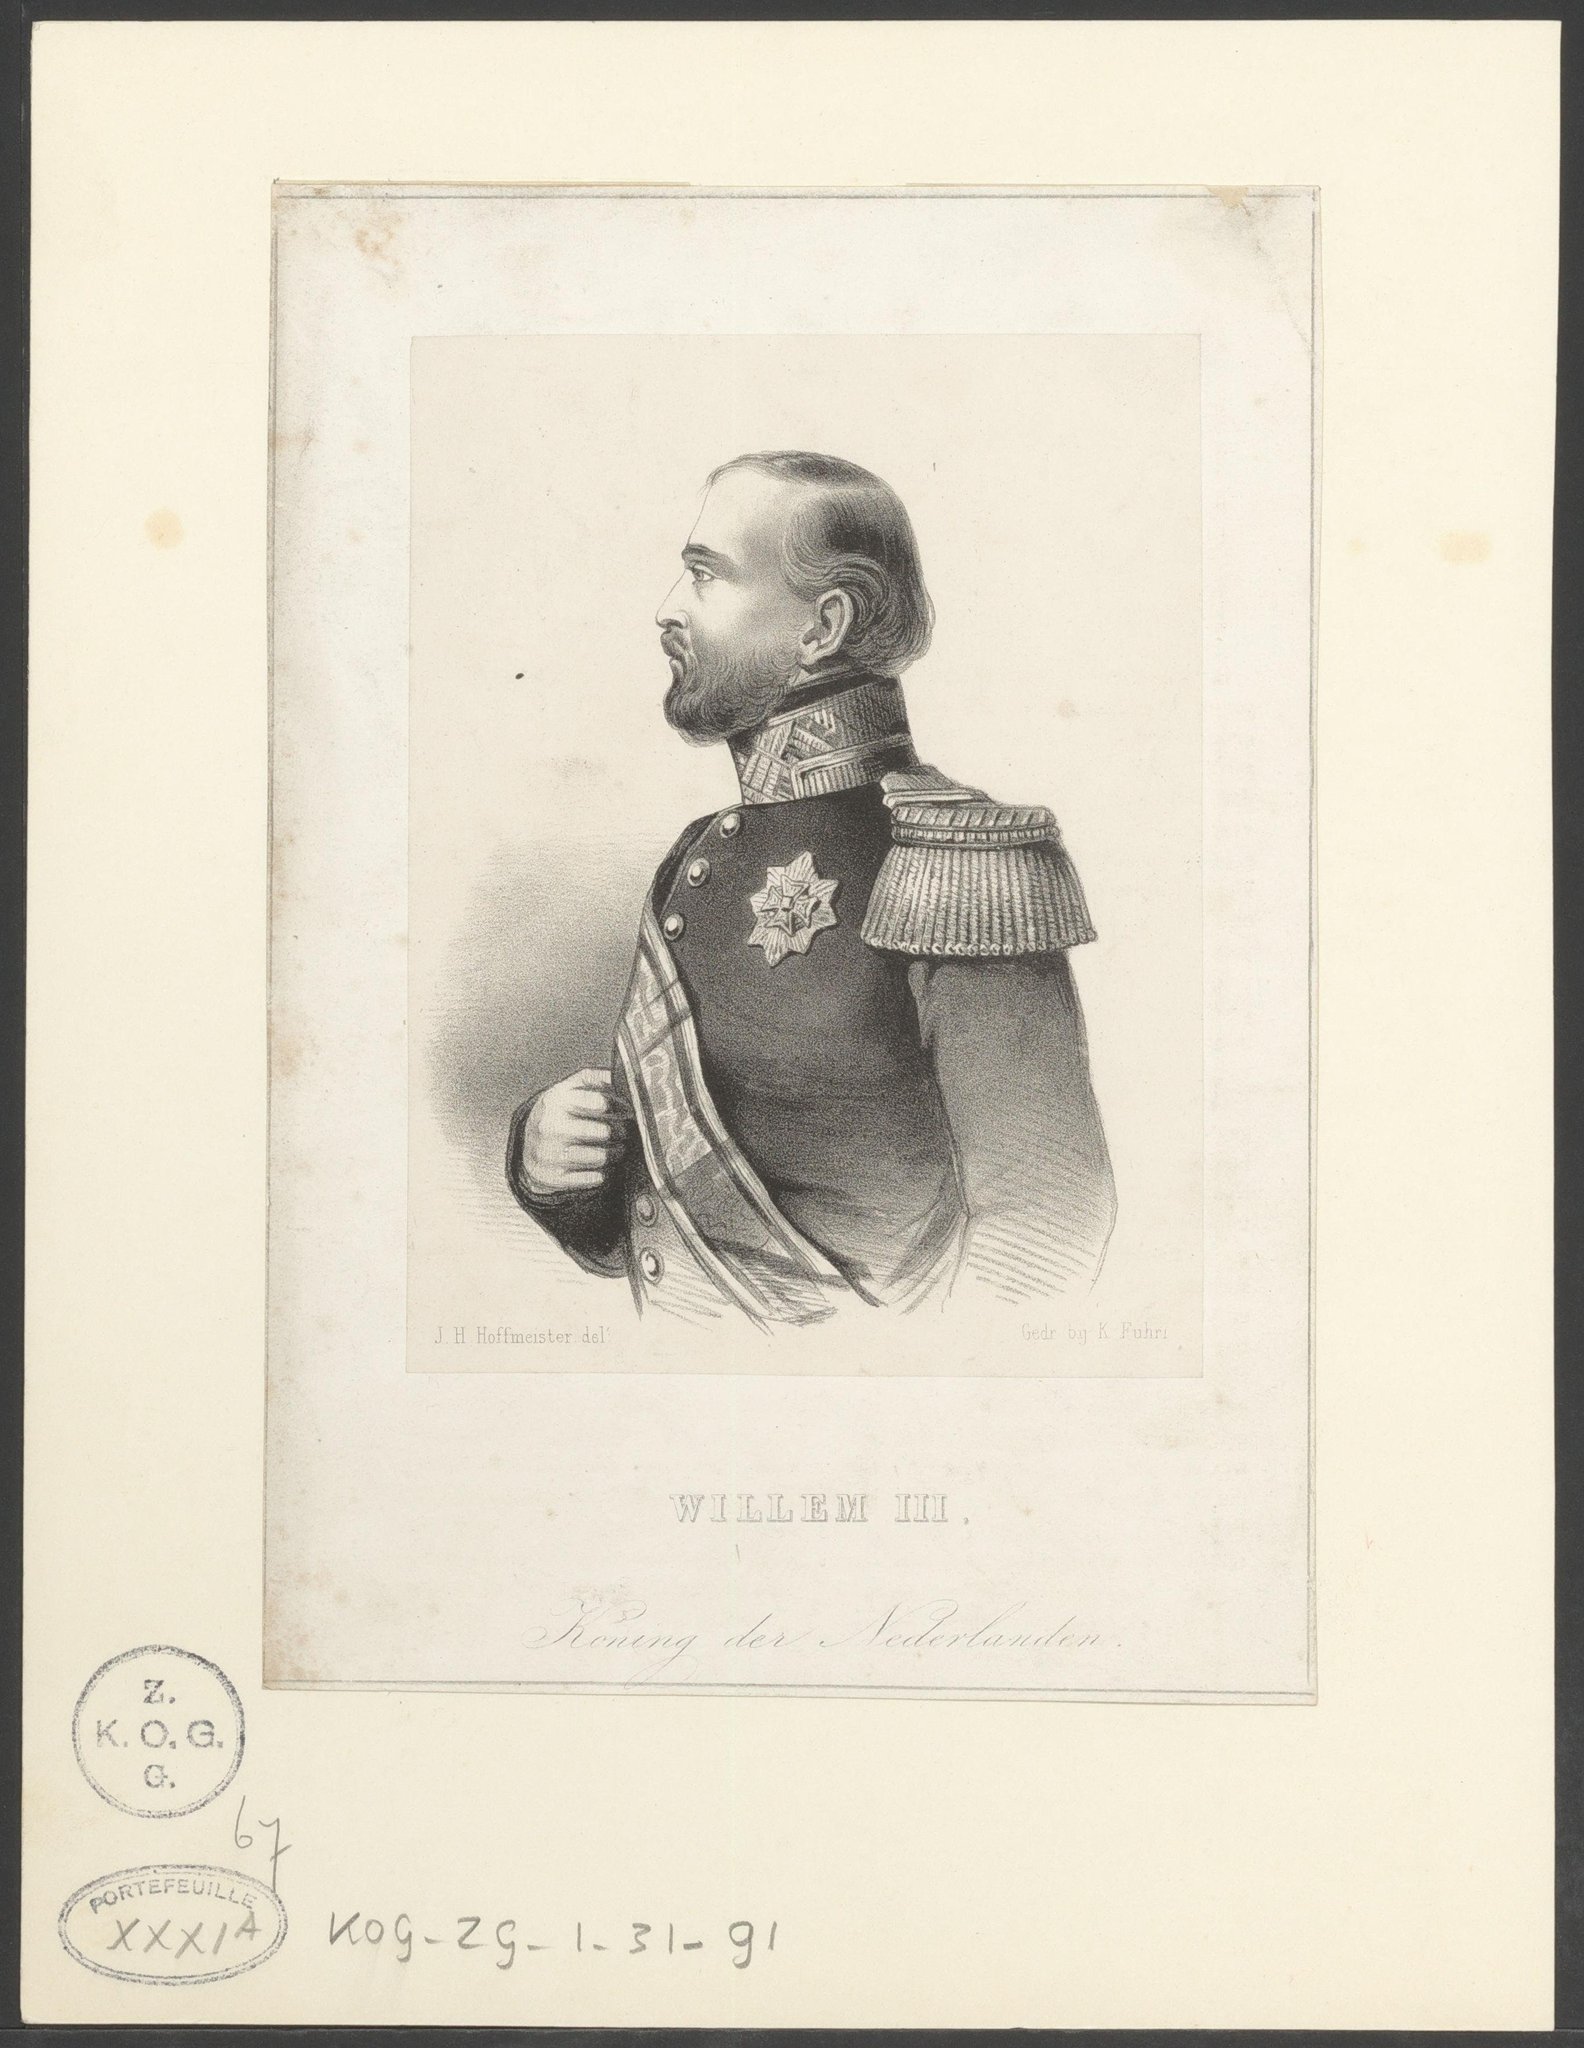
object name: print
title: Willem III, Koning der Nederlanden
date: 1849-1853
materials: paper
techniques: lithograph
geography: the hague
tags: brussels, willem iii (koning der nederlanden), historical persons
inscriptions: collector's mark: Lugt 1641, stamp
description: Onderwerpsrubrieken binnen de Atlas Zeden en Gewoonten: Portretten, Portretten van Vorsten uit het huis van Oranje, Regeerende Vorsten, Koningen uit het huis van Oranje.